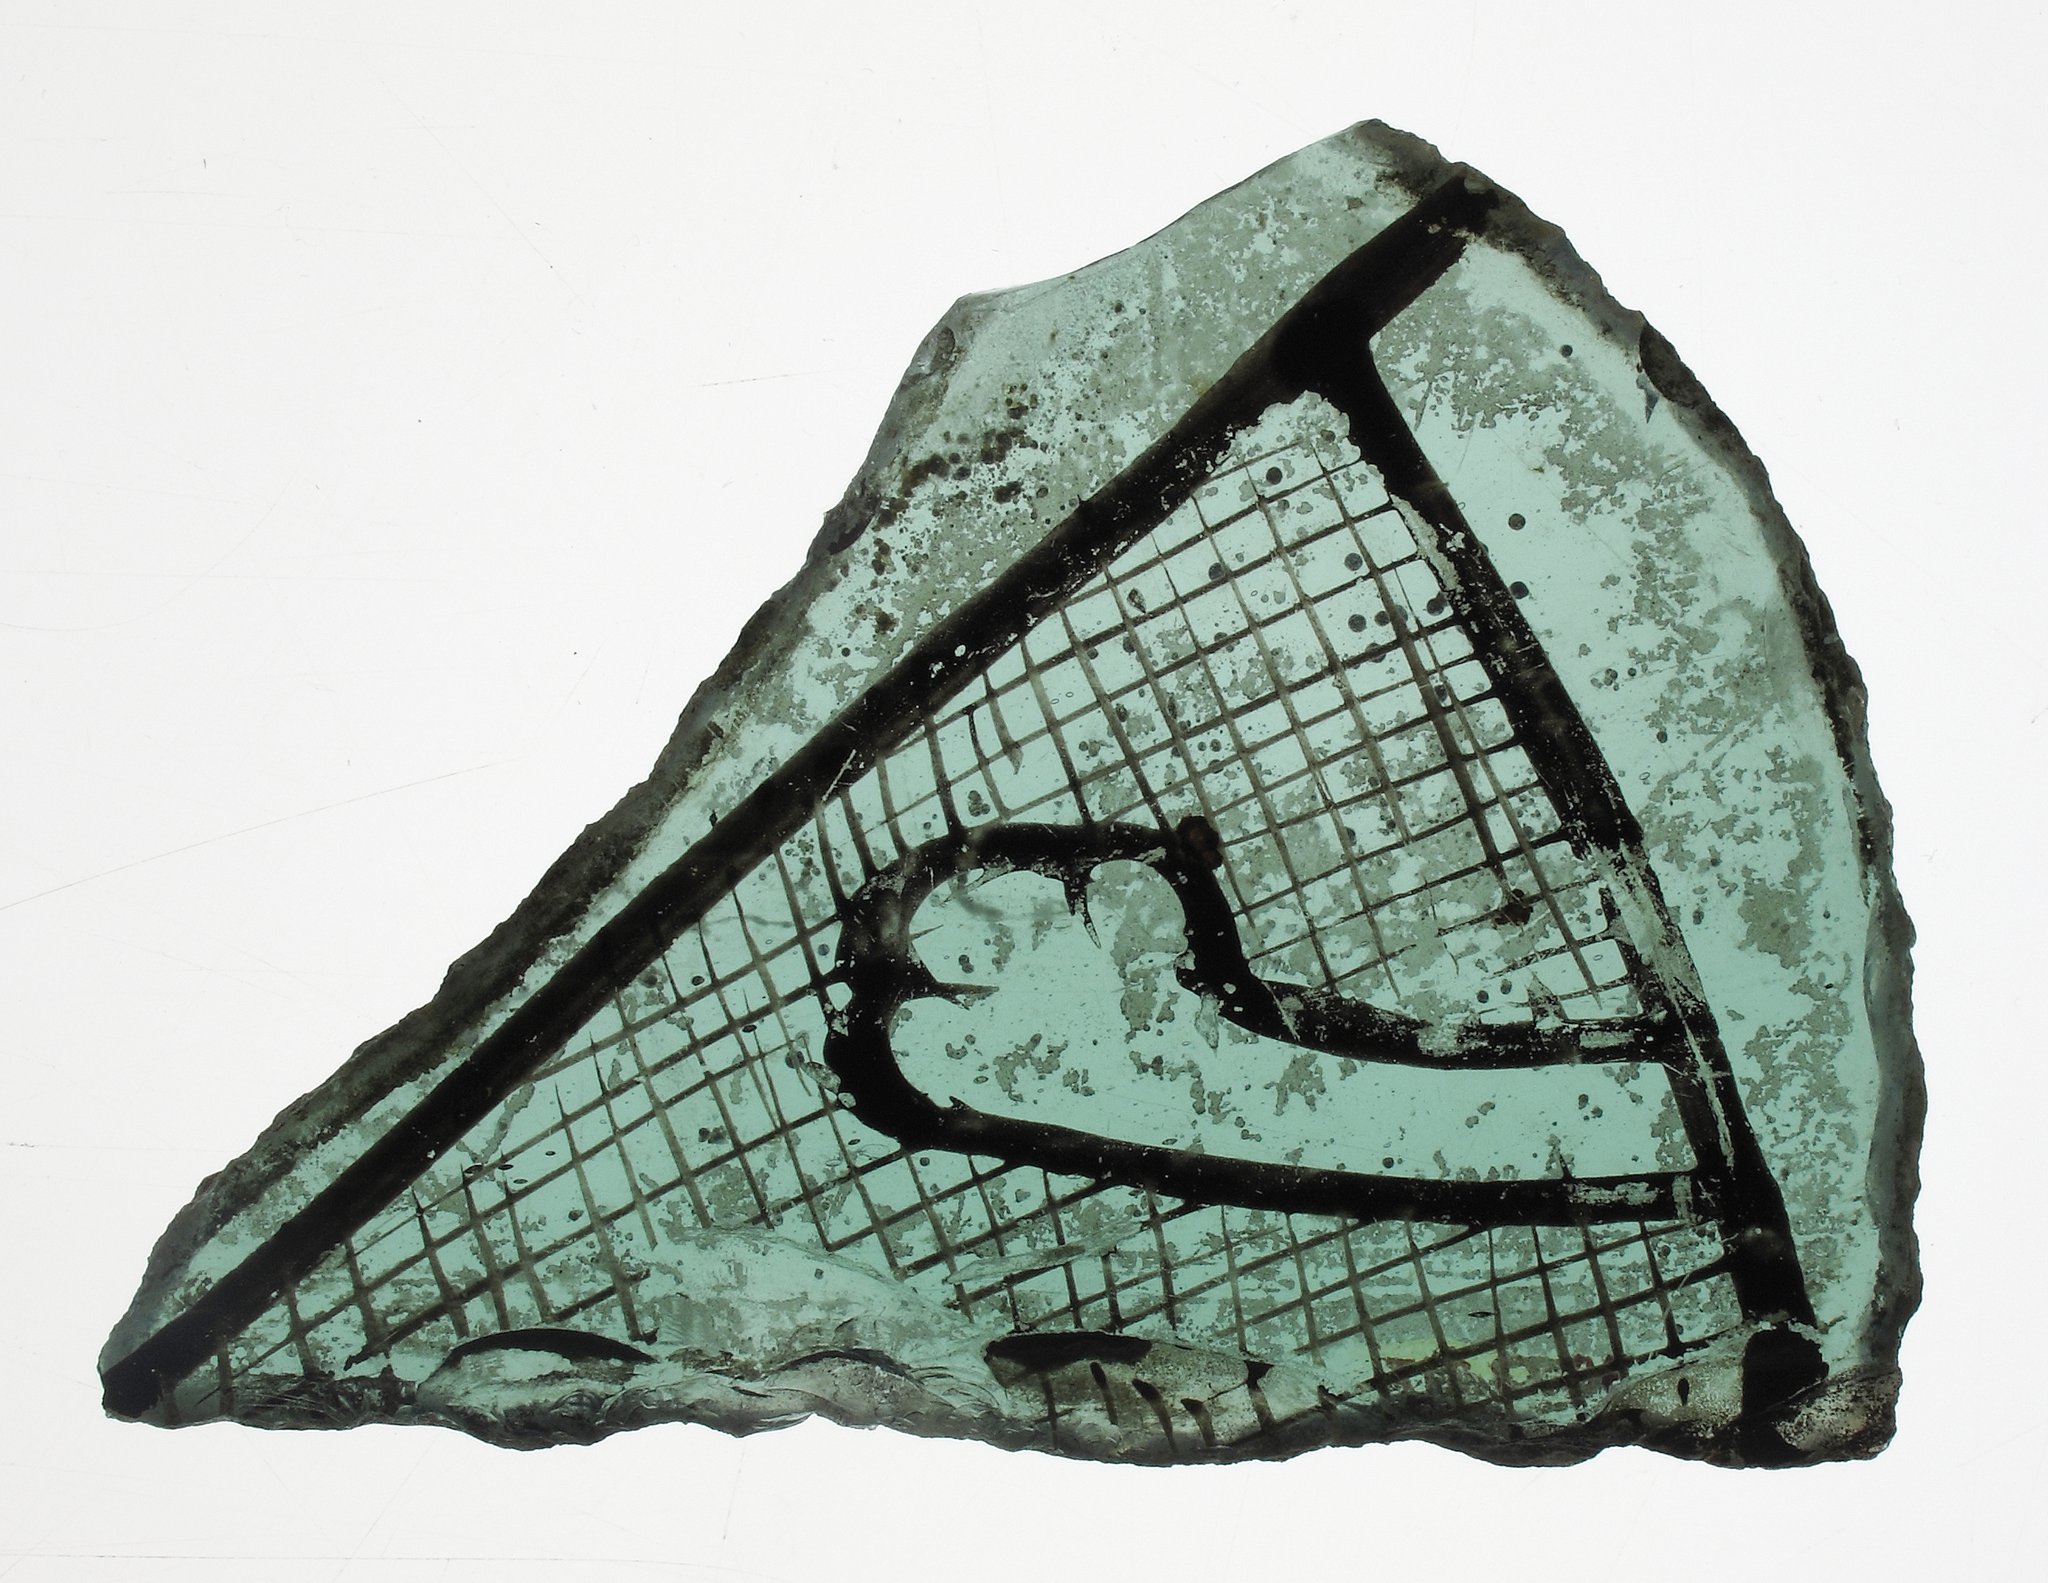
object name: fragment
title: Glass Fragment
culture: french or british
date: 1201-1400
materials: glass